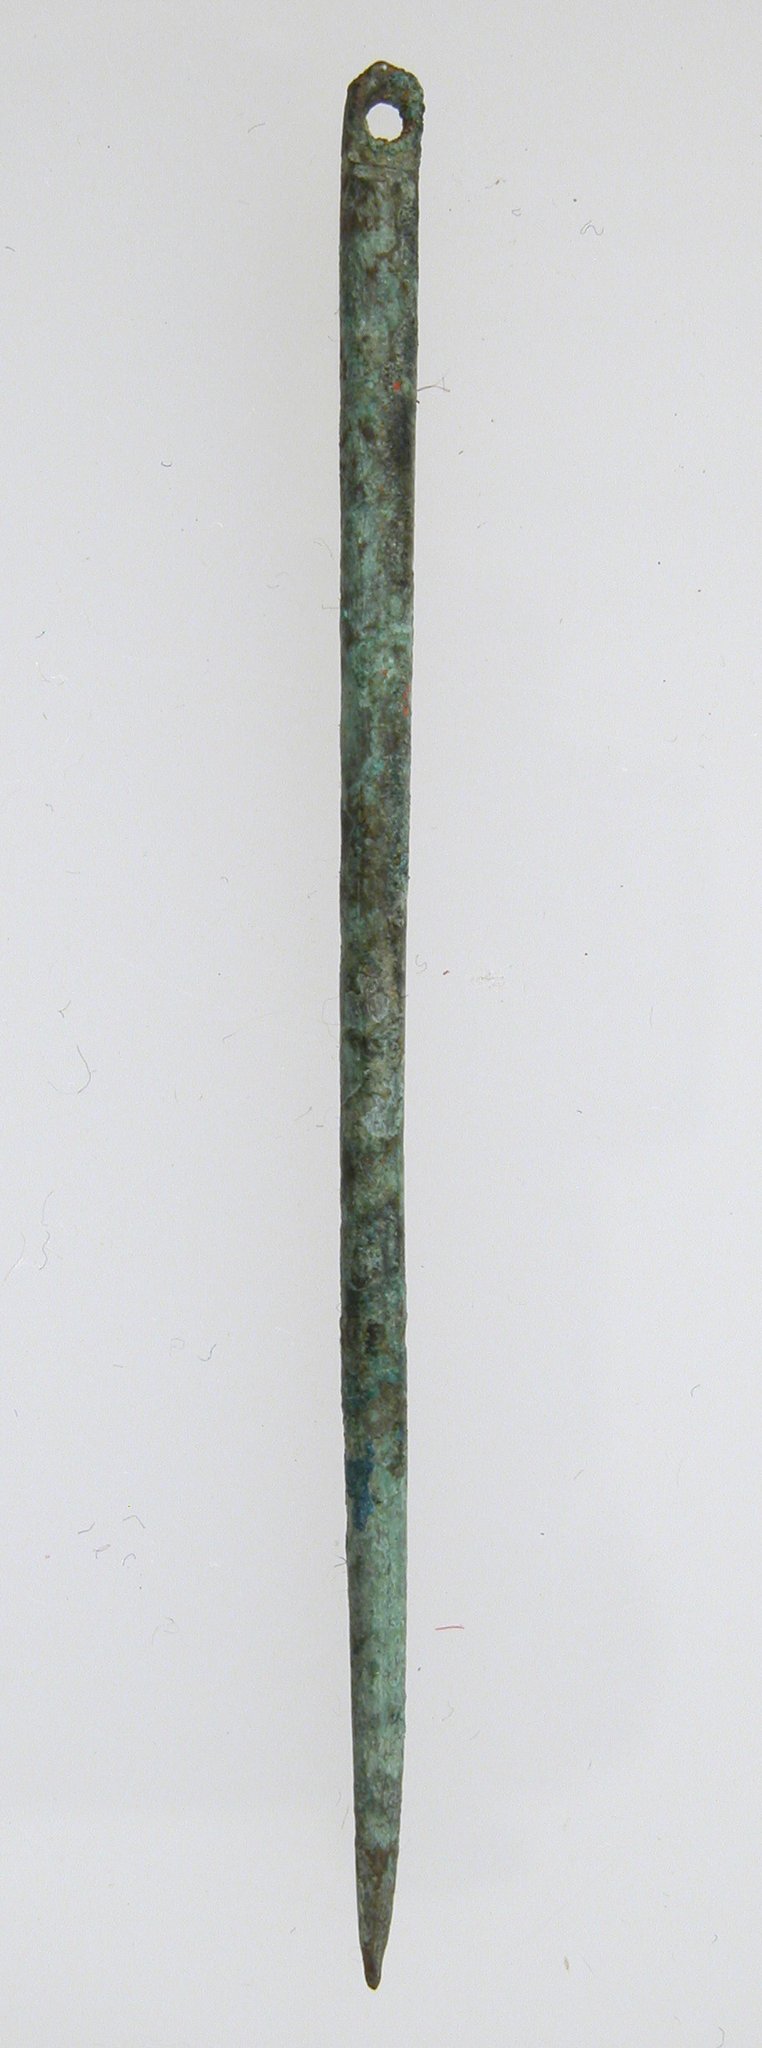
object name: needle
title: Plain Needle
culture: roman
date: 200-500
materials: copper alloy